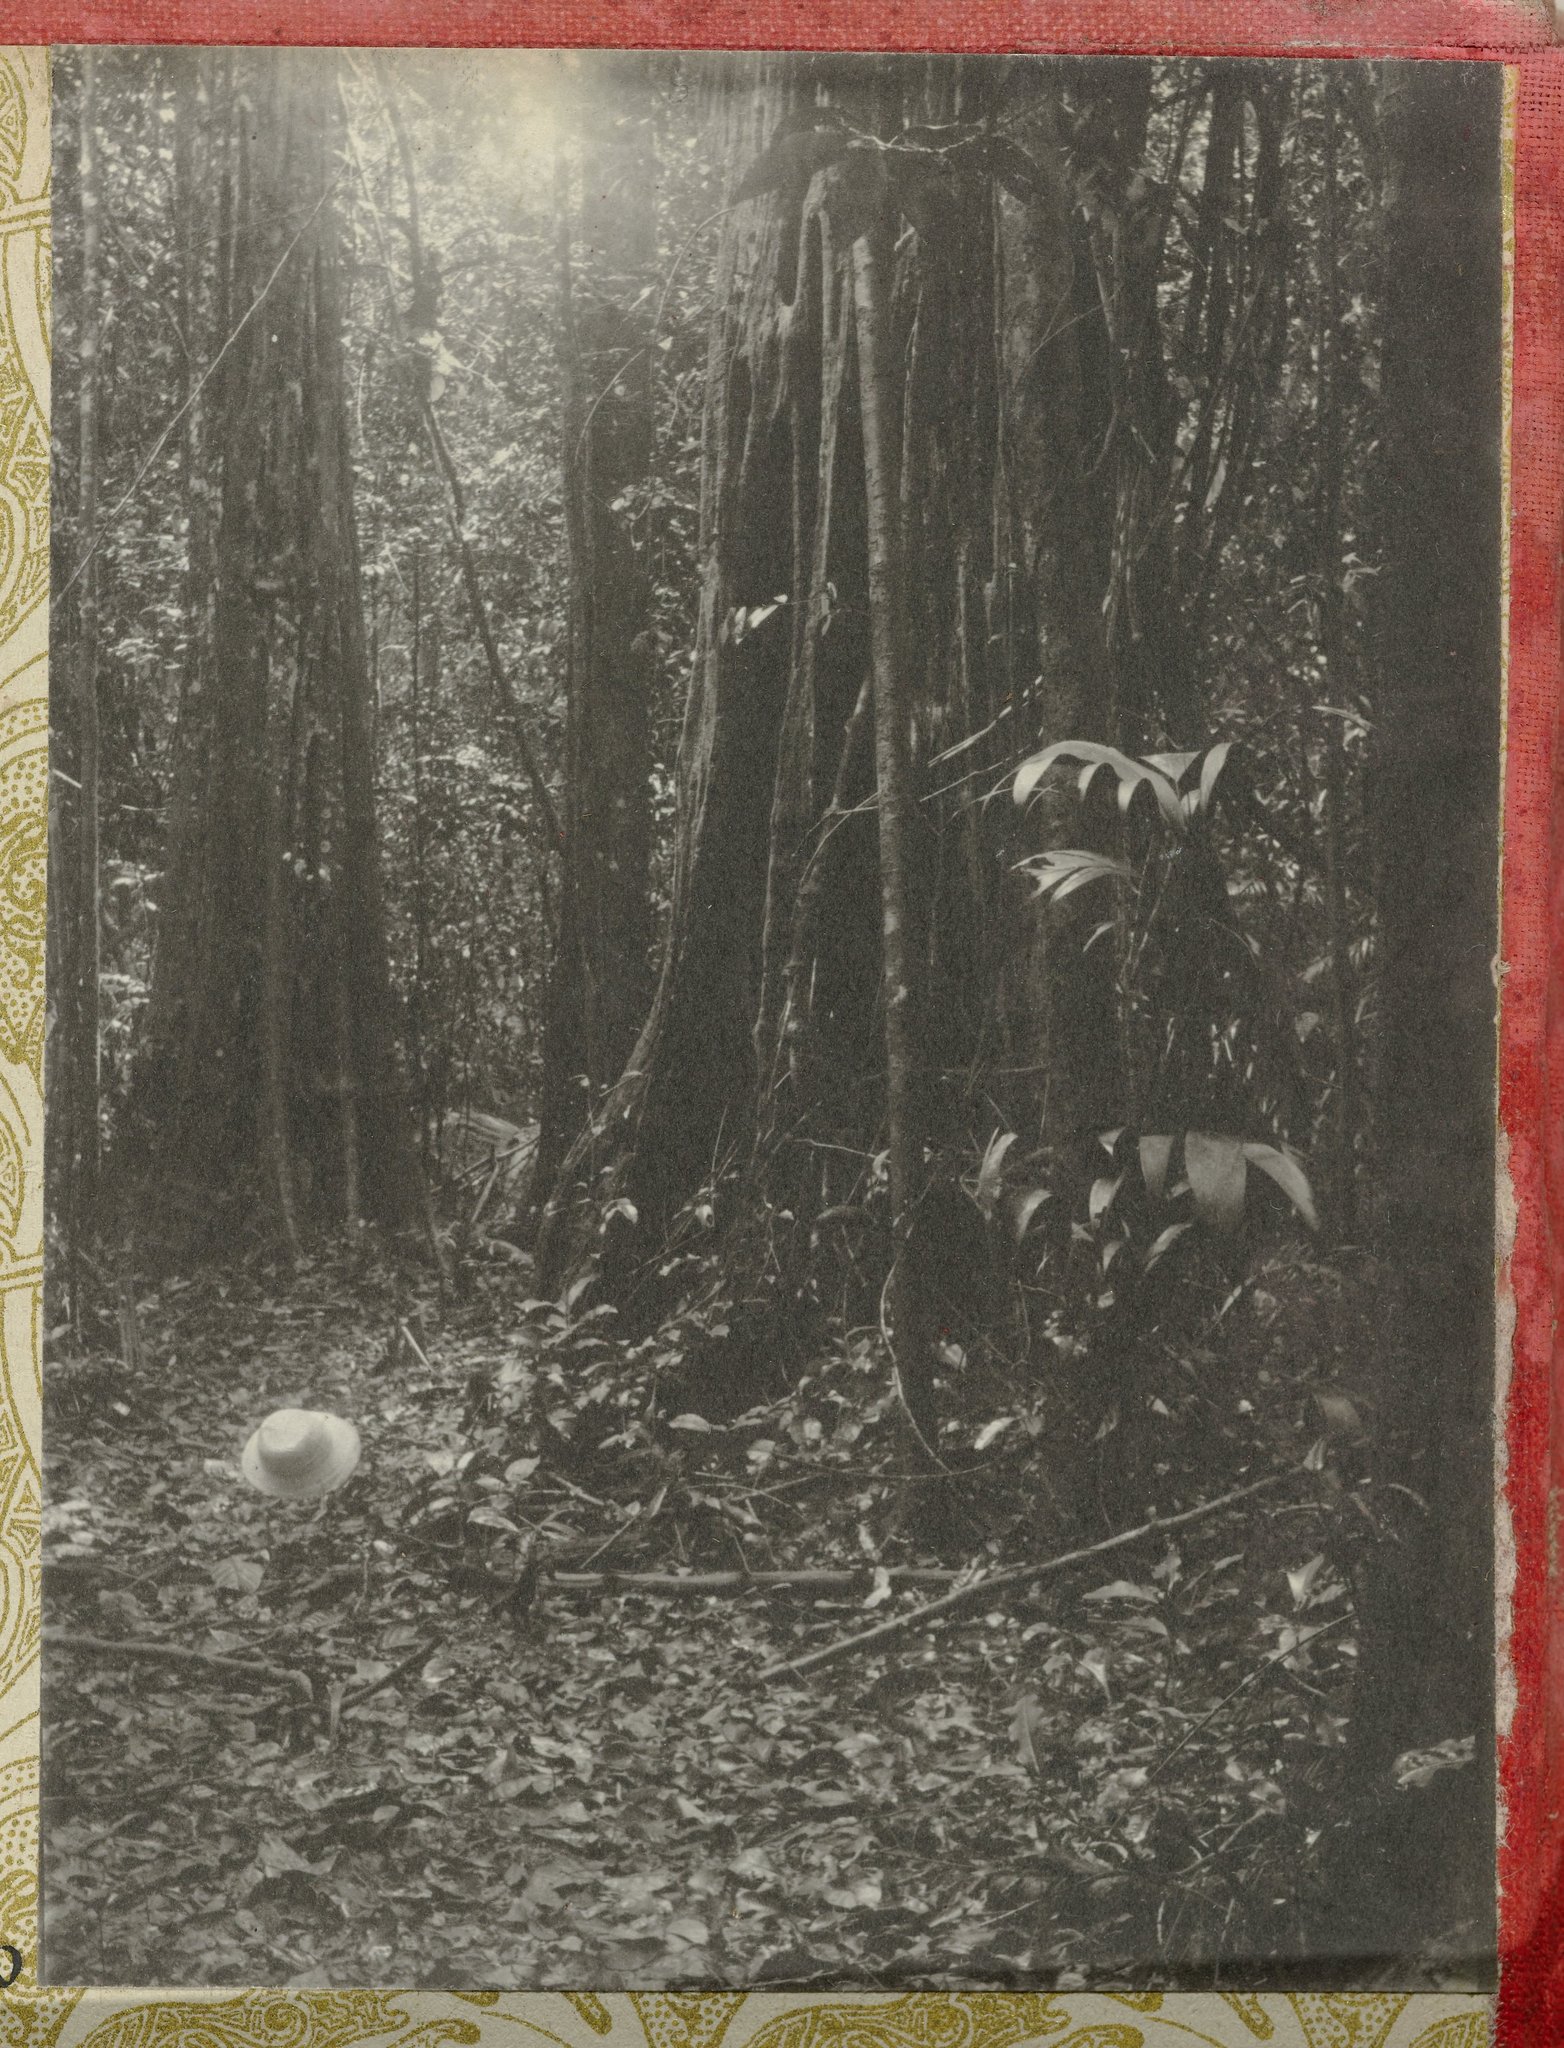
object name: photograph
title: Bomen in het oerwoud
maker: hendrik doijer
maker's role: engineer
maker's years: 1863-1925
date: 1903-1910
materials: photographic support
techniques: gelatin silver print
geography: suriname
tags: suriname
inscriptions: inscription: ‘10’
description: Gezicht op bomen in het oerwoud, op de grond ligt een witte hoed. Onderdeel van het fotoalbum Souvenir de Voyage (deel 2), over het leven van de familie Doijer in en rond de plantage Ma Retraite in Suriname in de jaren 1903-1910.